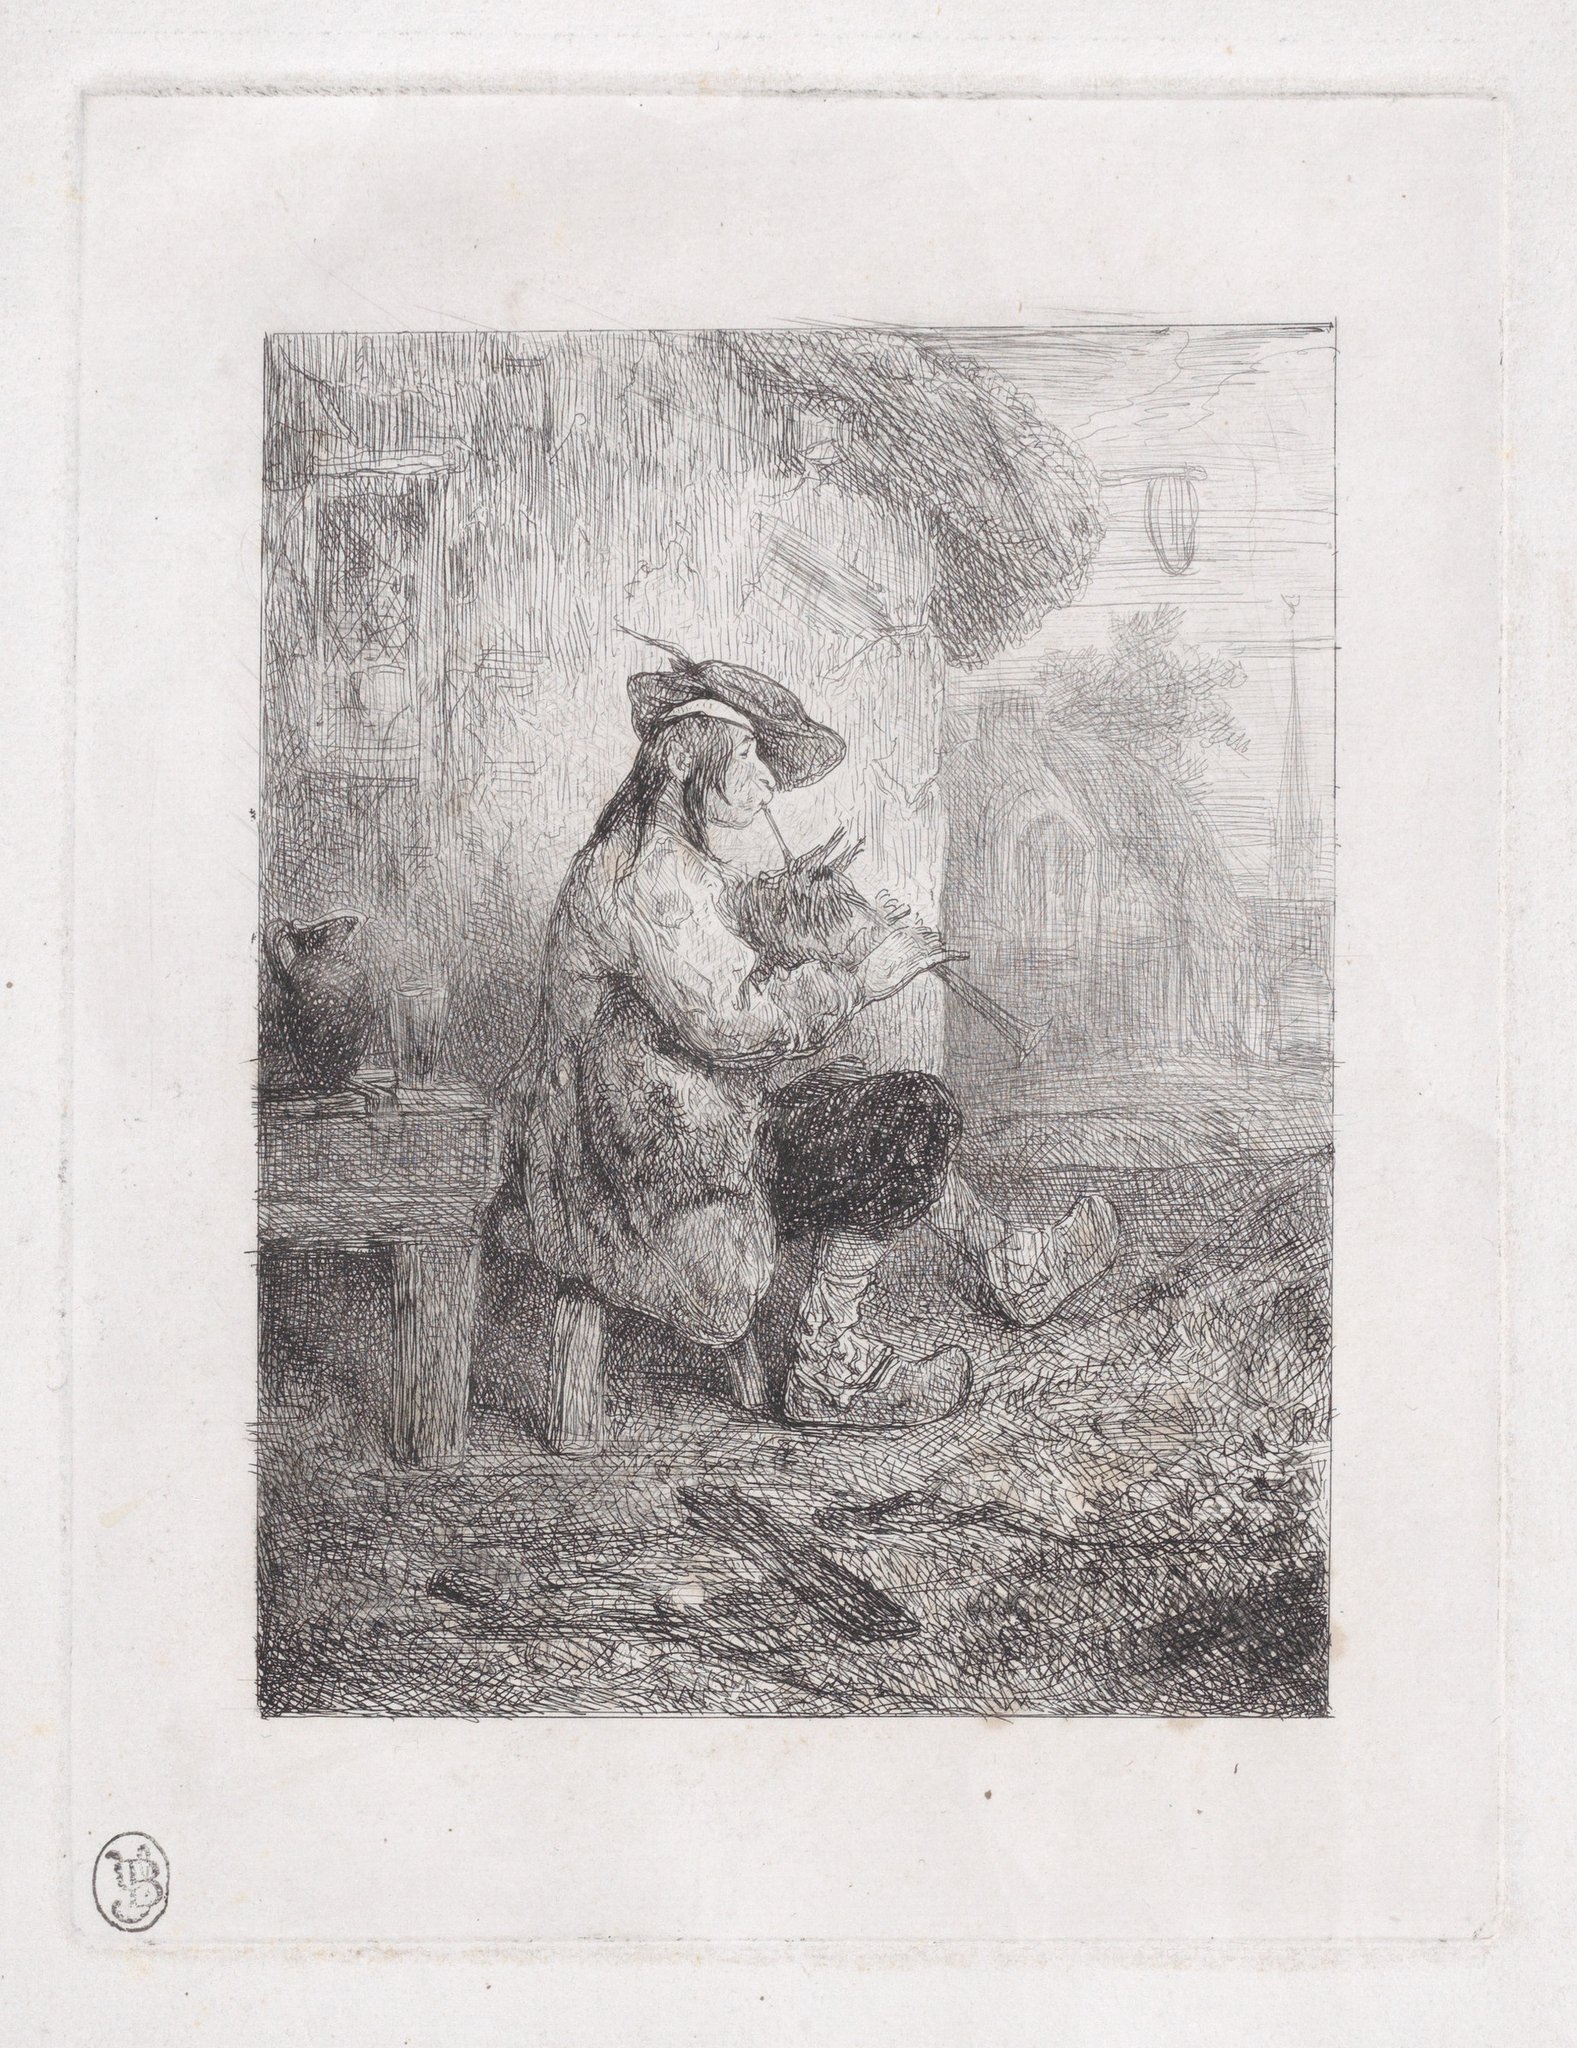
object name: print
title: The Bagpiper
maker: alexandre-gabriel decamps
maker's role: artist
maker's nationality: french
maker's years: 1803-1860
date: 1833-1838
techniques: drypoint, etching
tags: men,bagpipes